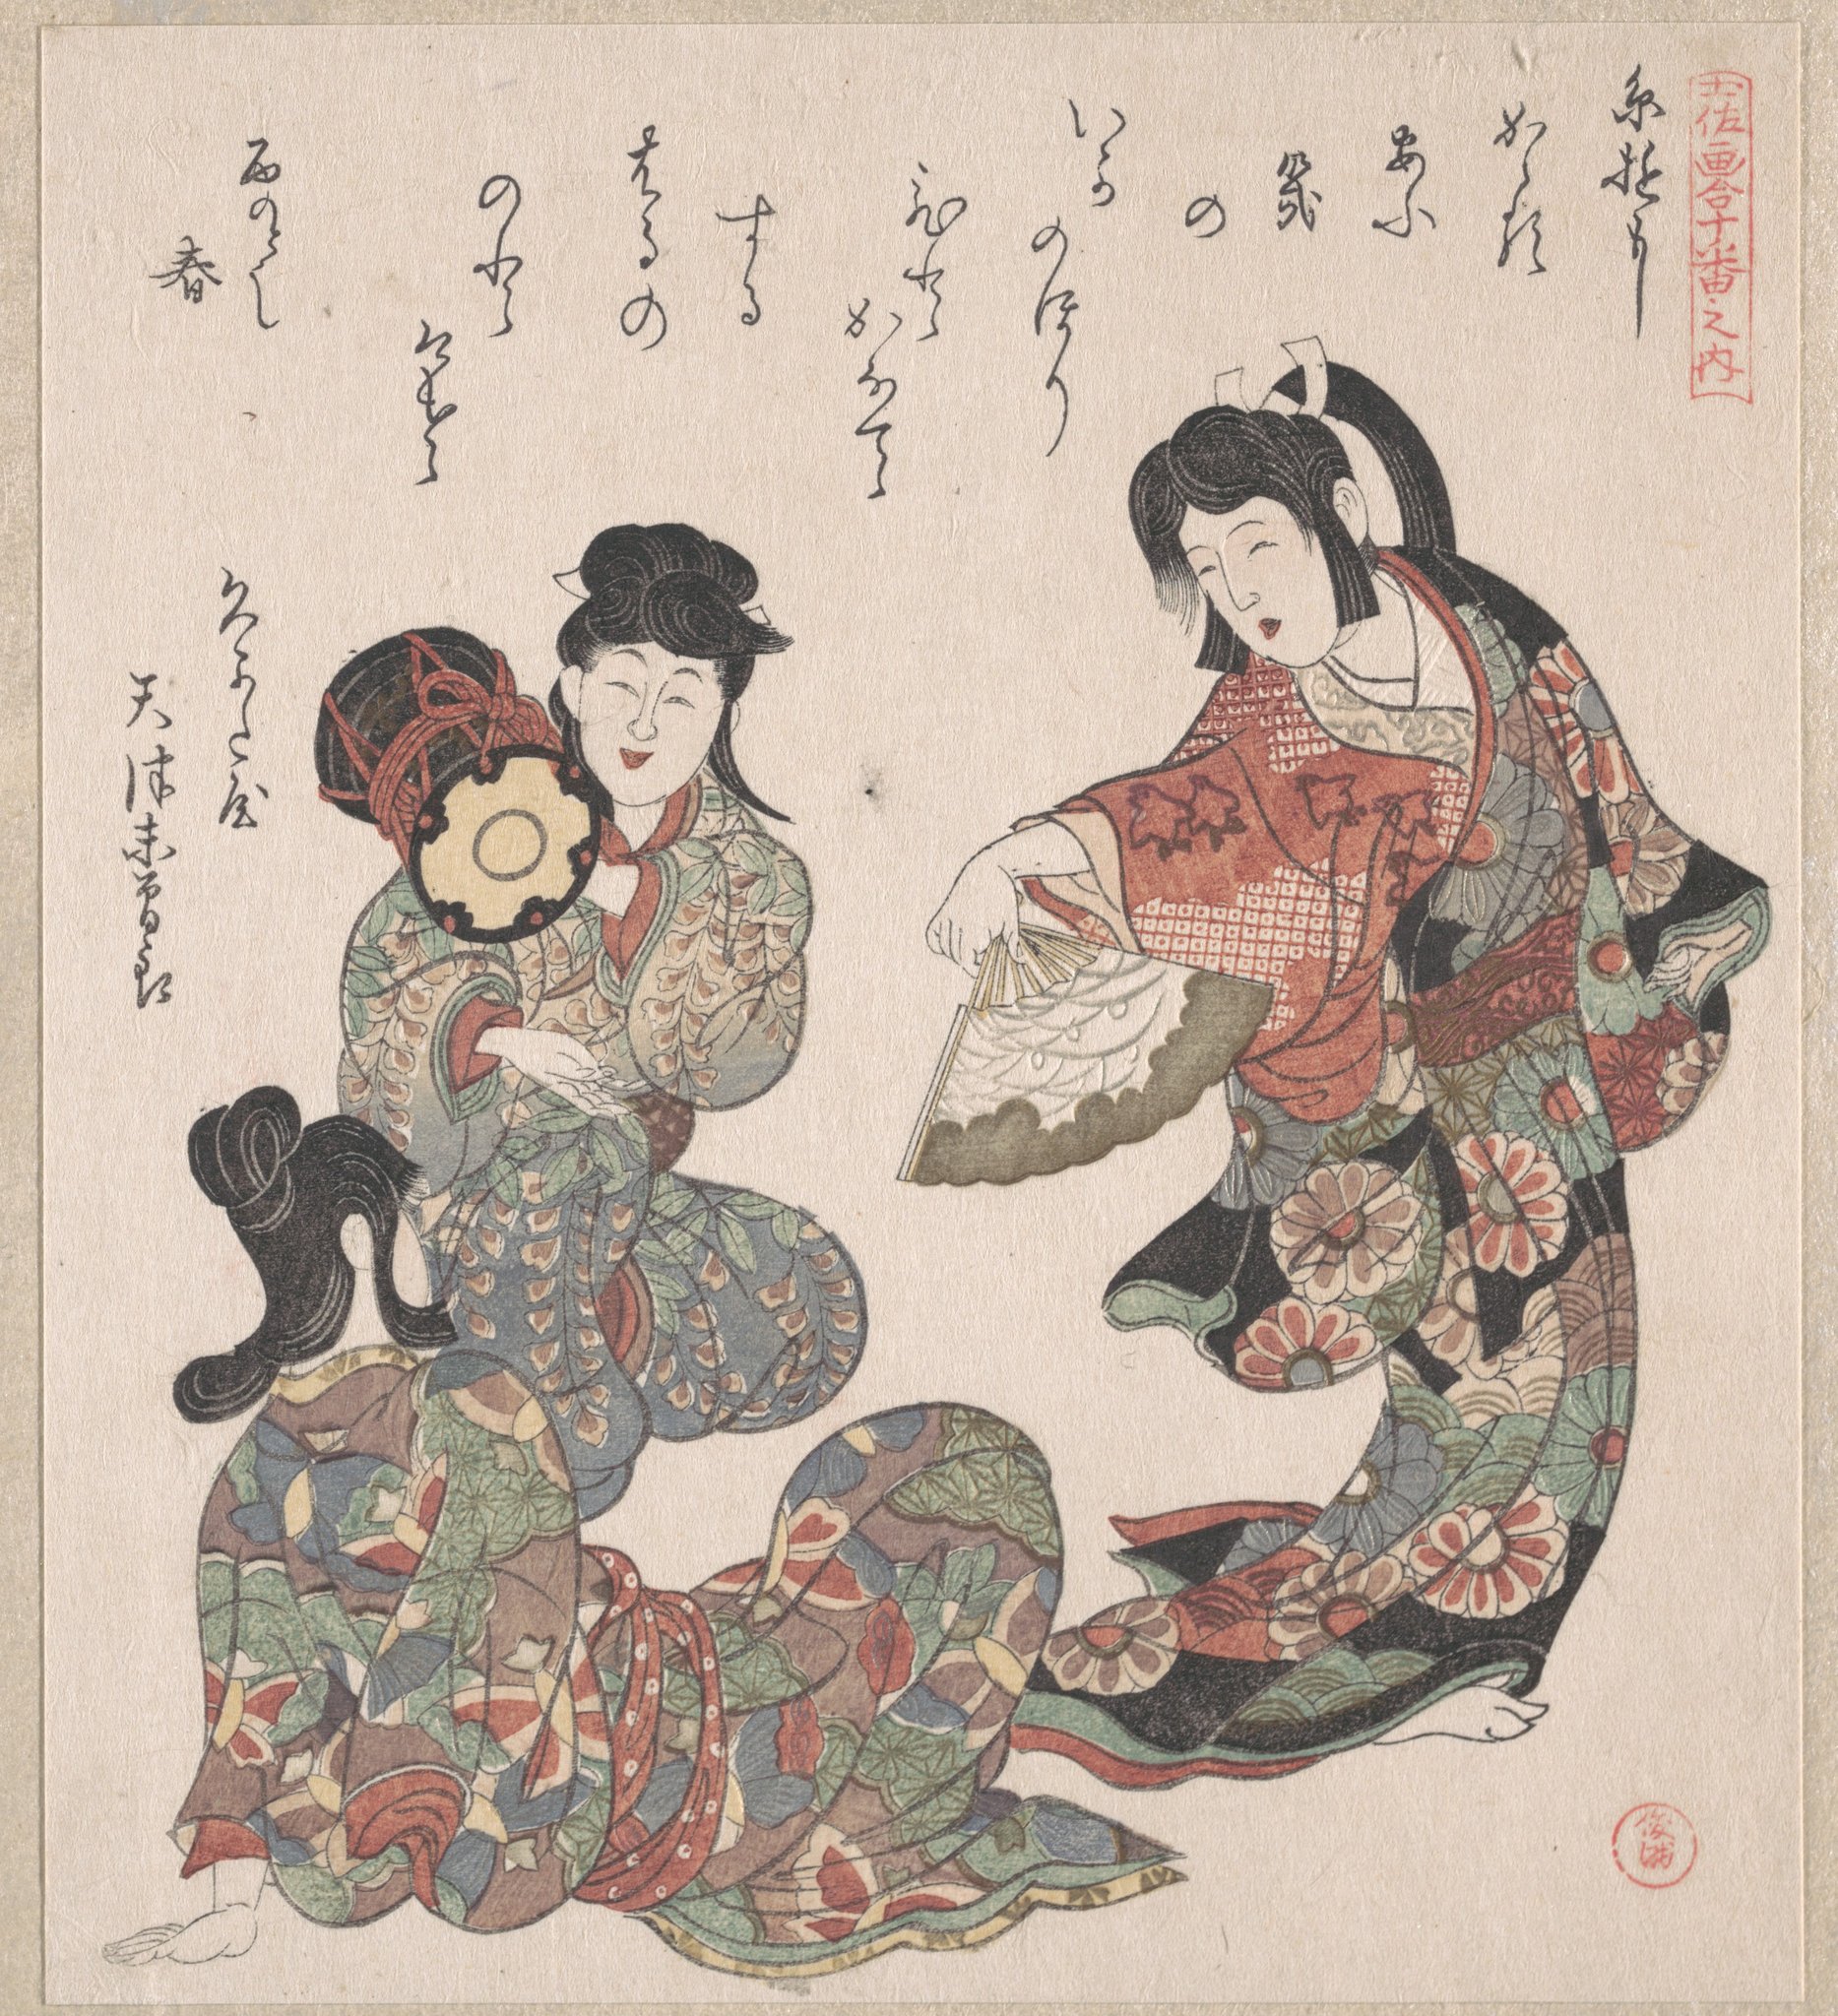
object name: print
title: Three Girls Singing and Dancing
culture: japanese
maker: kubo shunman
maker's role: artist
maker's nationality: japanese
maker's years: 1757-1820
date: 1815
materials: ink, paper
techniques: surimono, woodblock print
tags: fans,girls,singing,dancing,drums